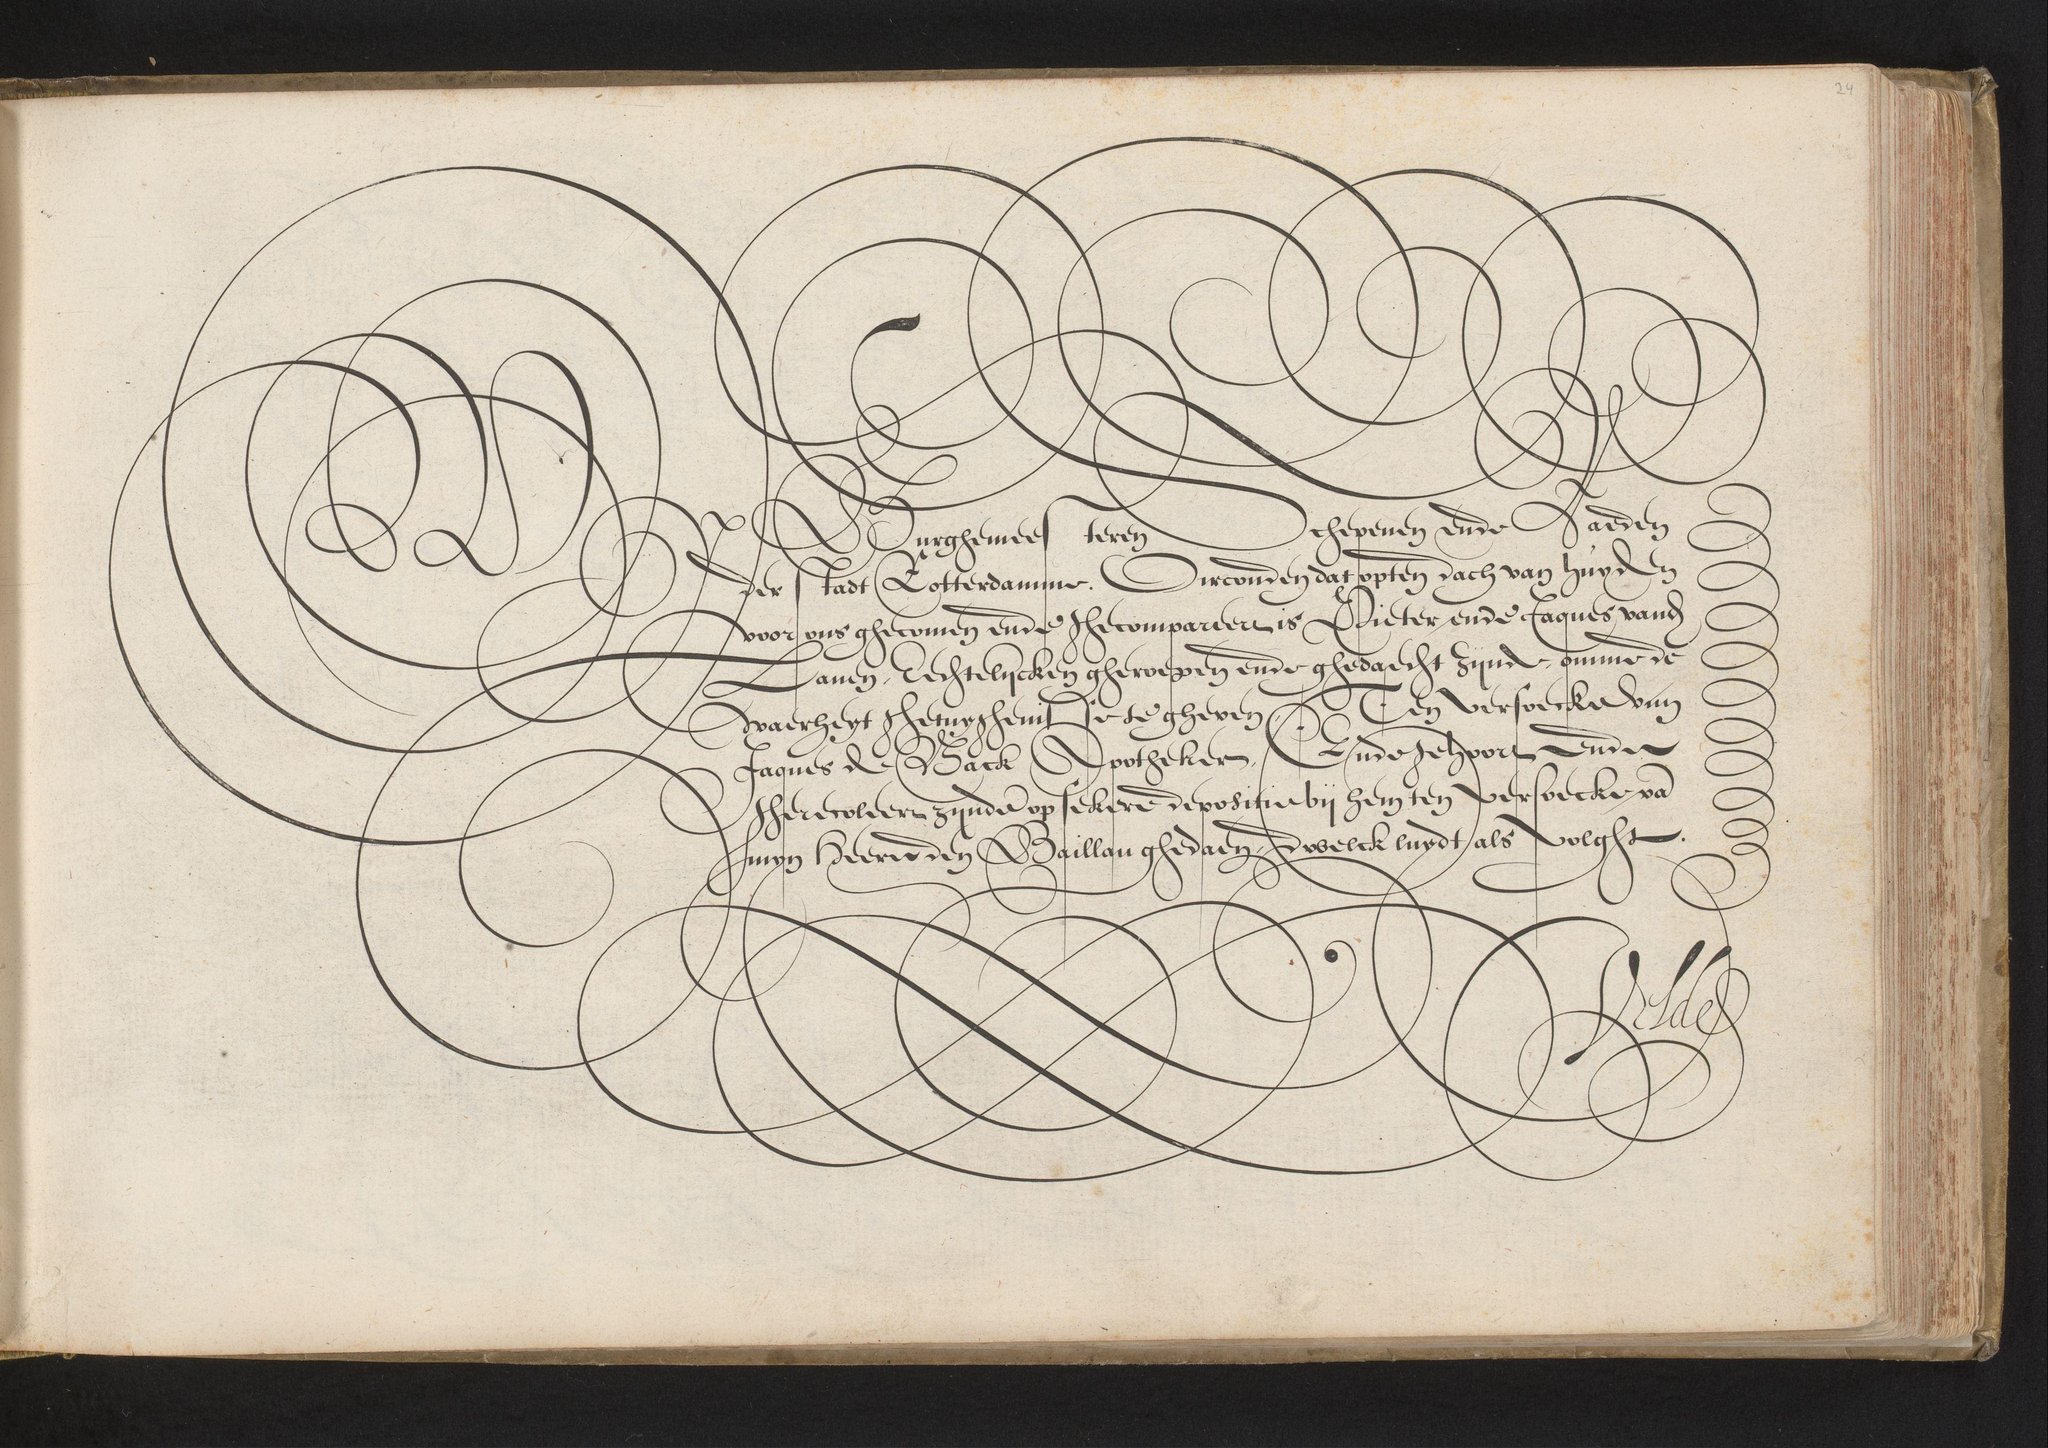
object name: ornament print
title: Schrijfvoorbeeld: De Burghemeesteren (...)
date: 1605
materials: paper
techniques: engraving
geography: rotterdam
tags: calligraphy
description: Schrijfvoorbeeld met acht regels tekst in het Nederlands: De Burghemeesteren Schepenen ende Raeden der stadt Rotterdamme ... De tekst is omlijst door krulwerk. De prent maakt deel uit van een album.